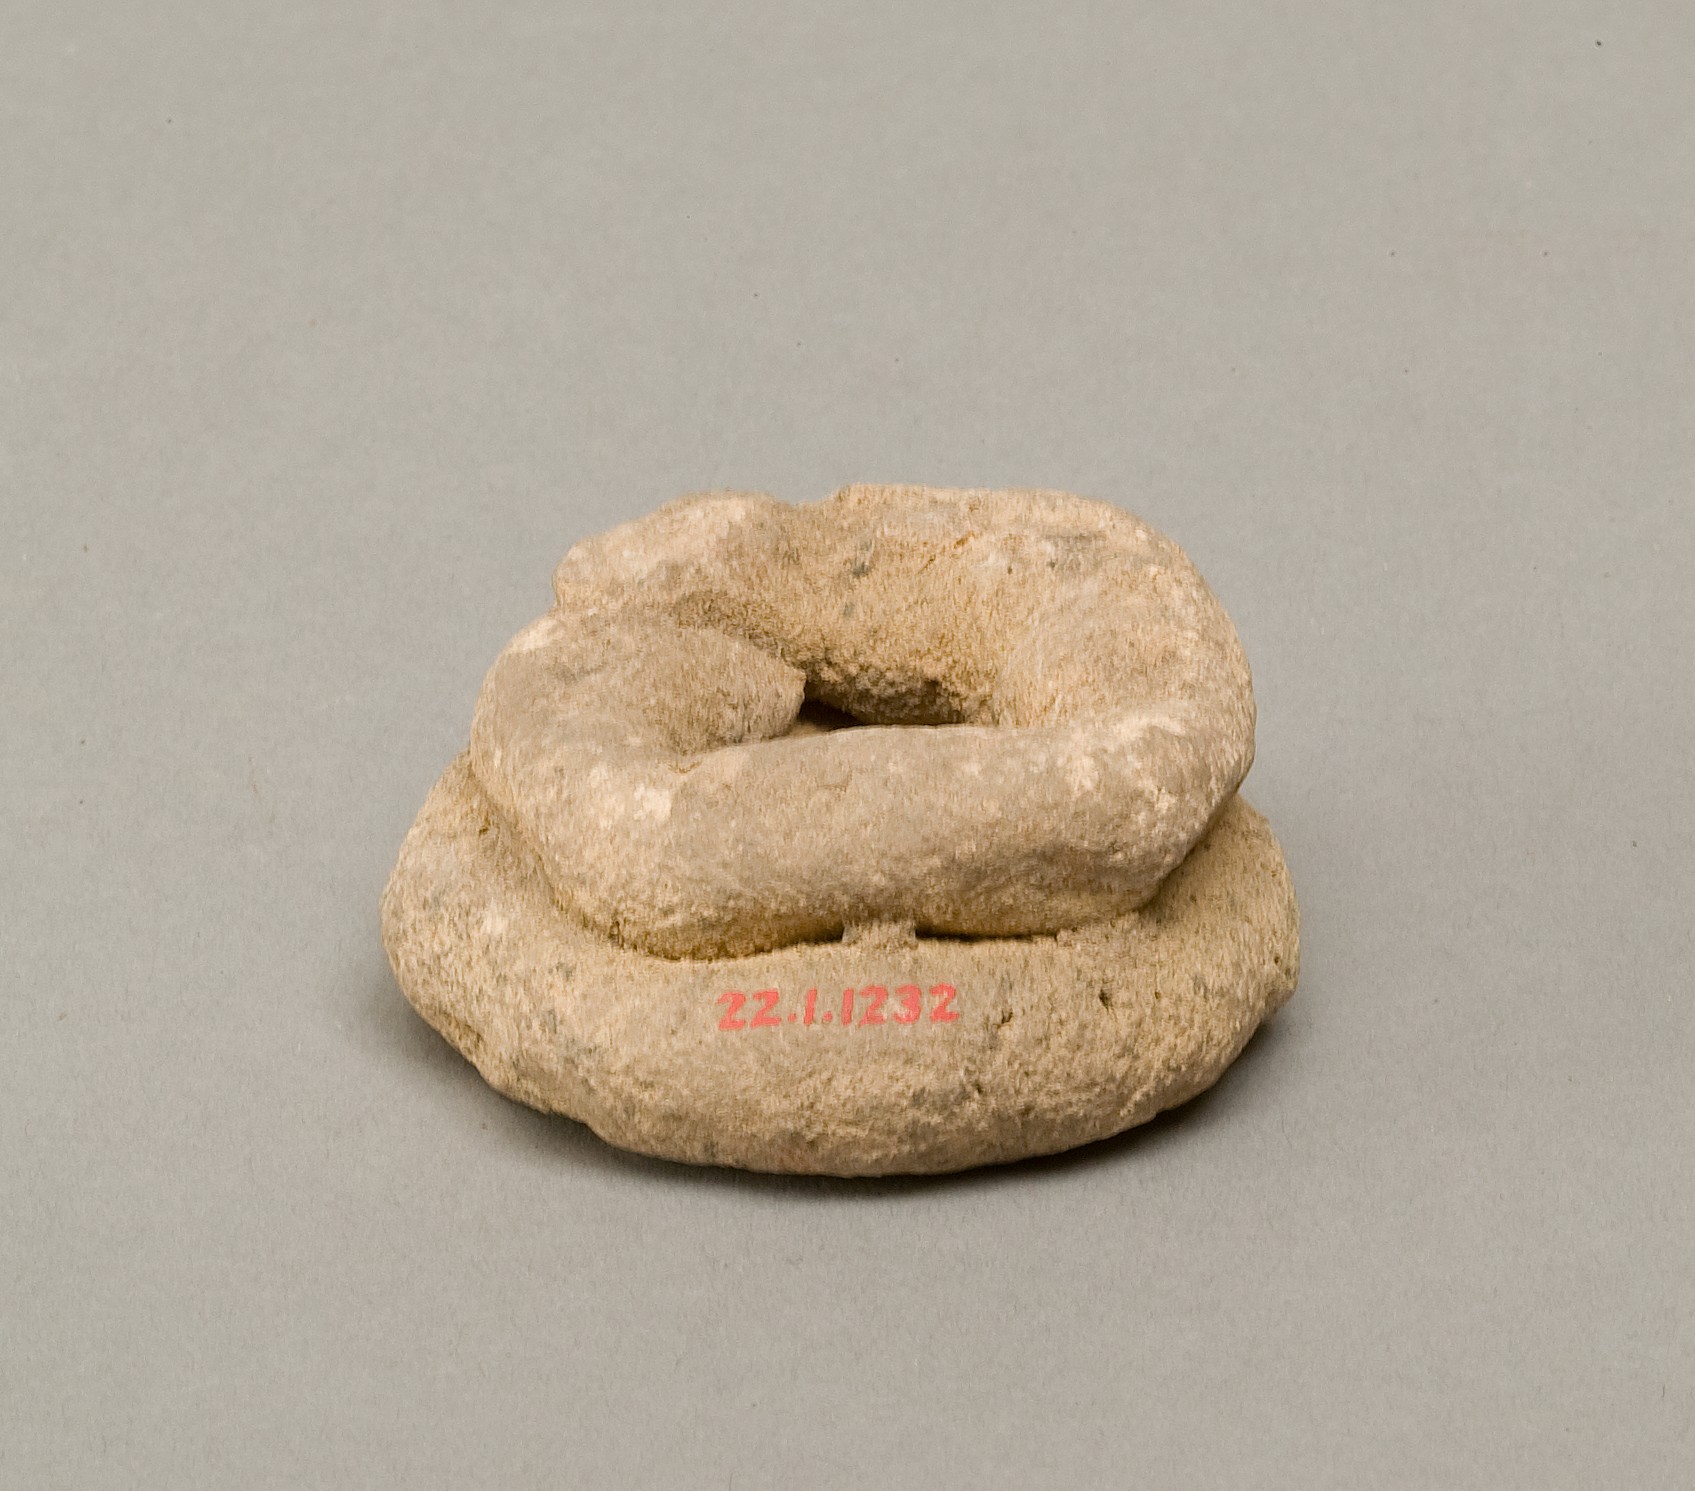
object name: fragment, clay section, donut shaped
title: Faience workshop refuse, ring-shaped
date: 1802-1450 BCE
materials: clay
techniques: firing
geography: egypt